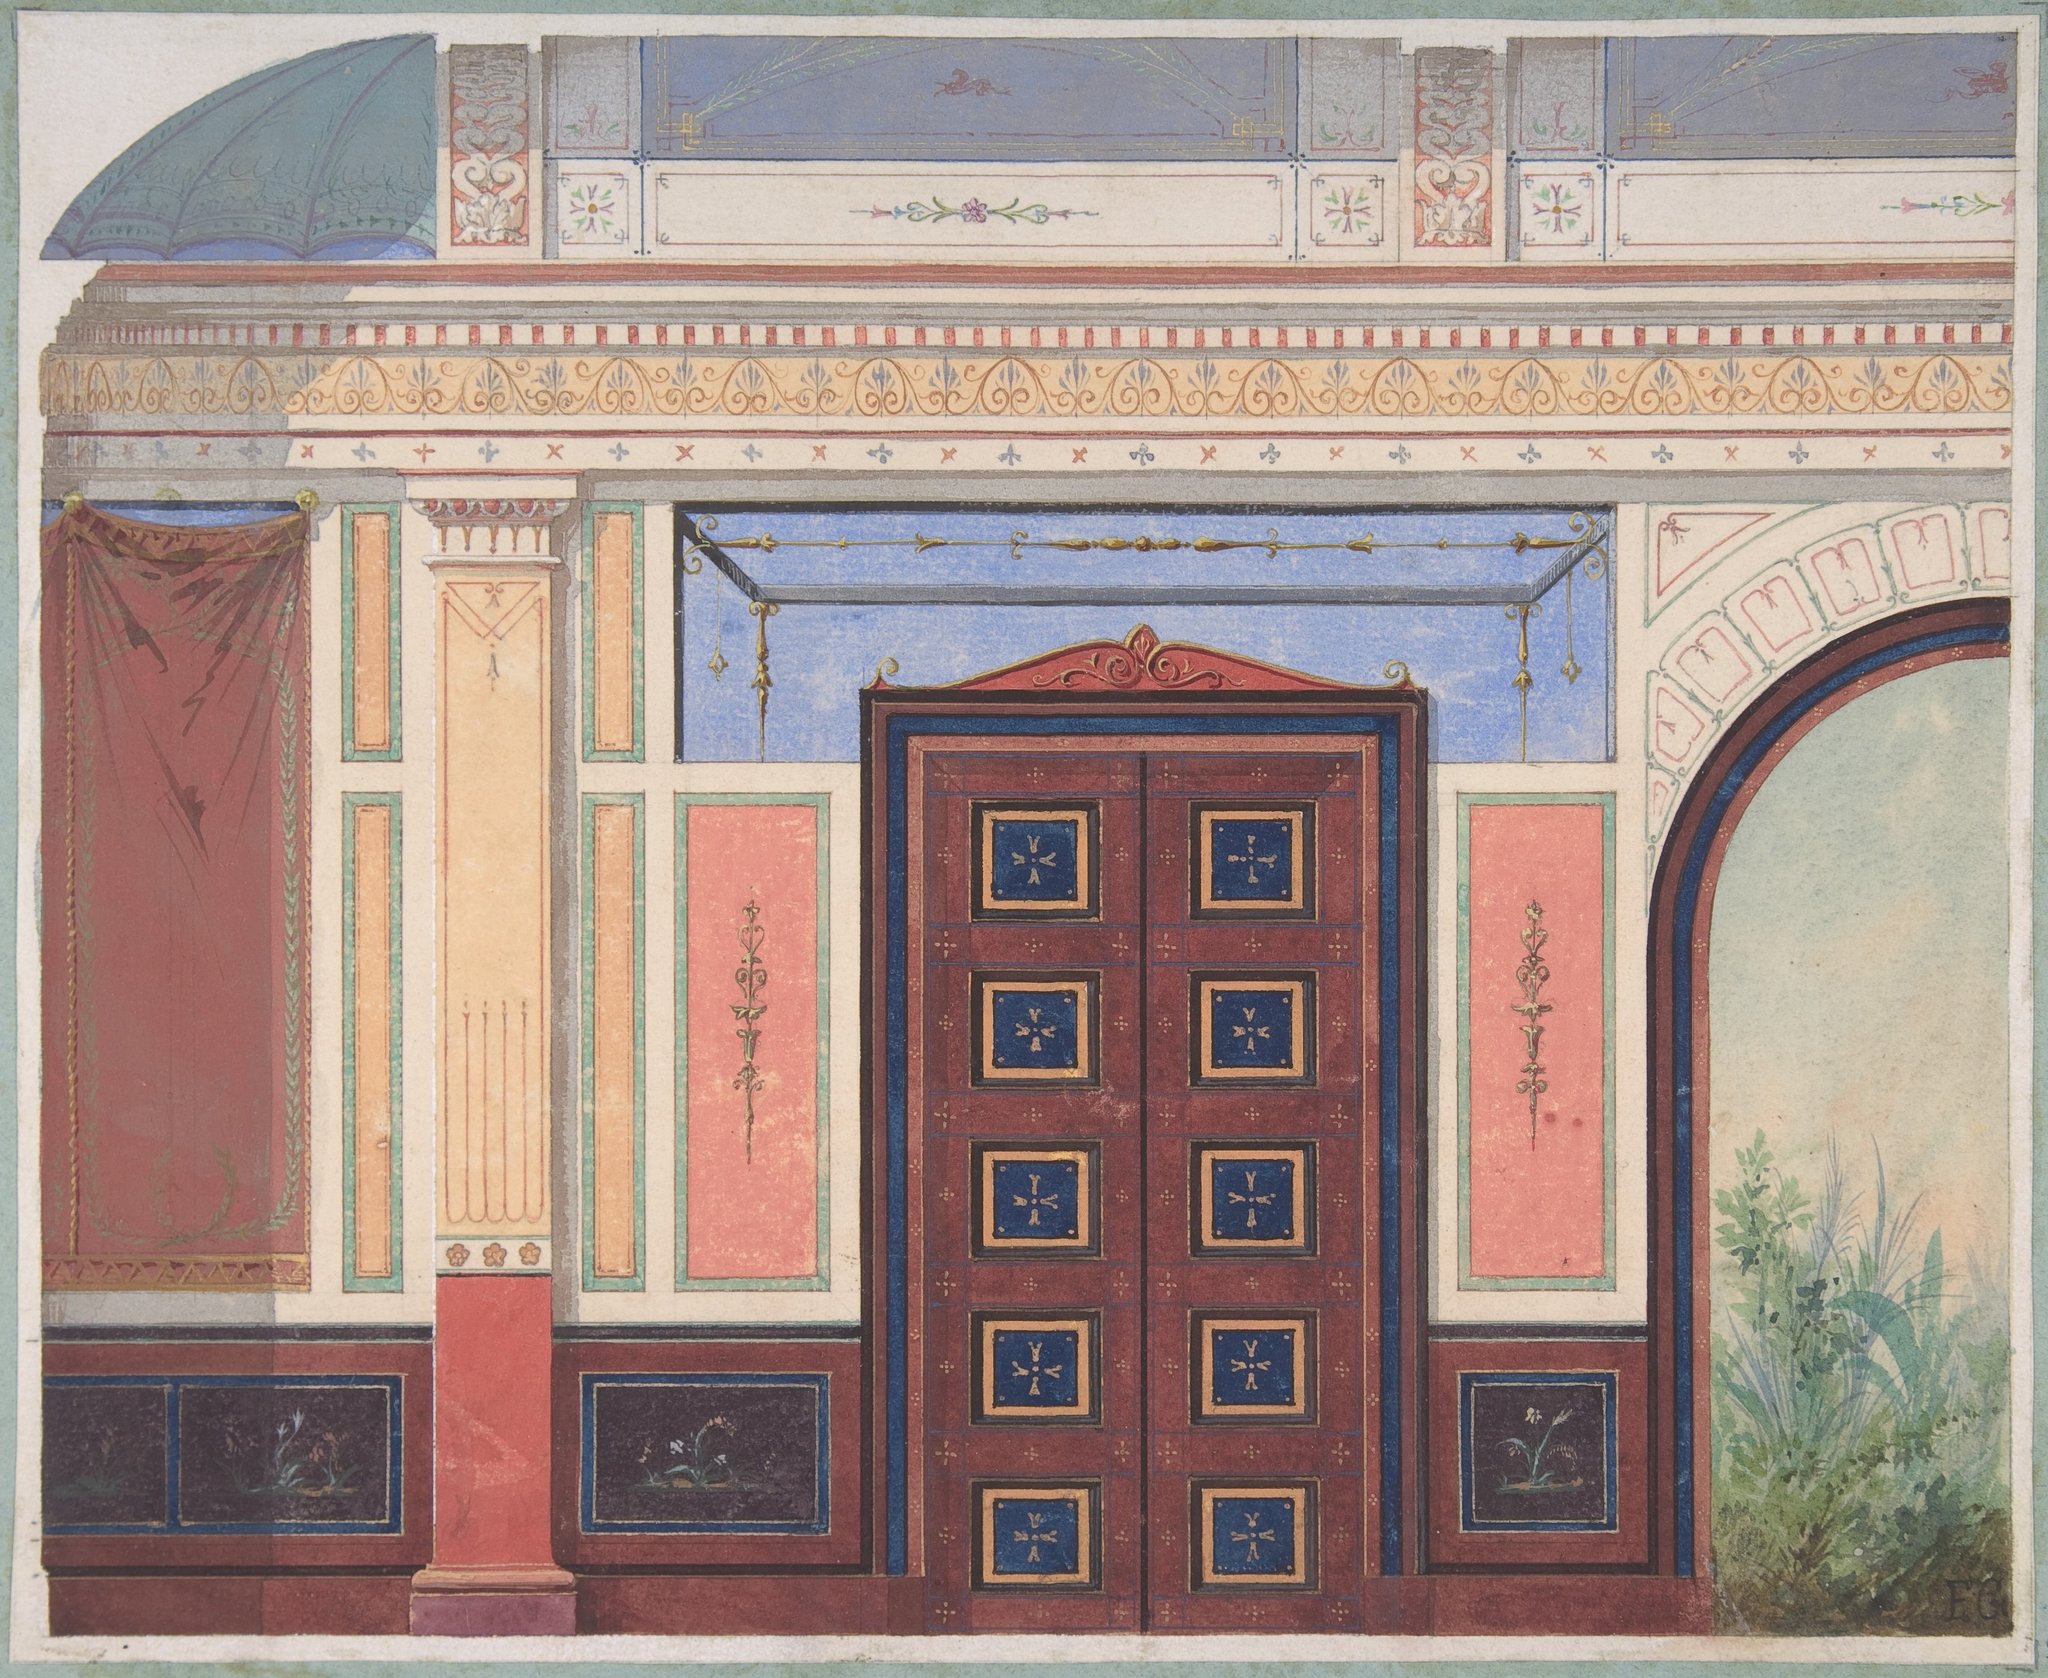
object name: drawing ornament architecture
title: Design for Elevation of Ceiling and Wall, Deepdene, Dorking, Surrey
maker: jules-edmond-charles lachaise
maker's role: artist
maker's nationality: french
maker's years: 1897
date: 1875-1879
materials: gouache, watercolor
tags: architecture,doors